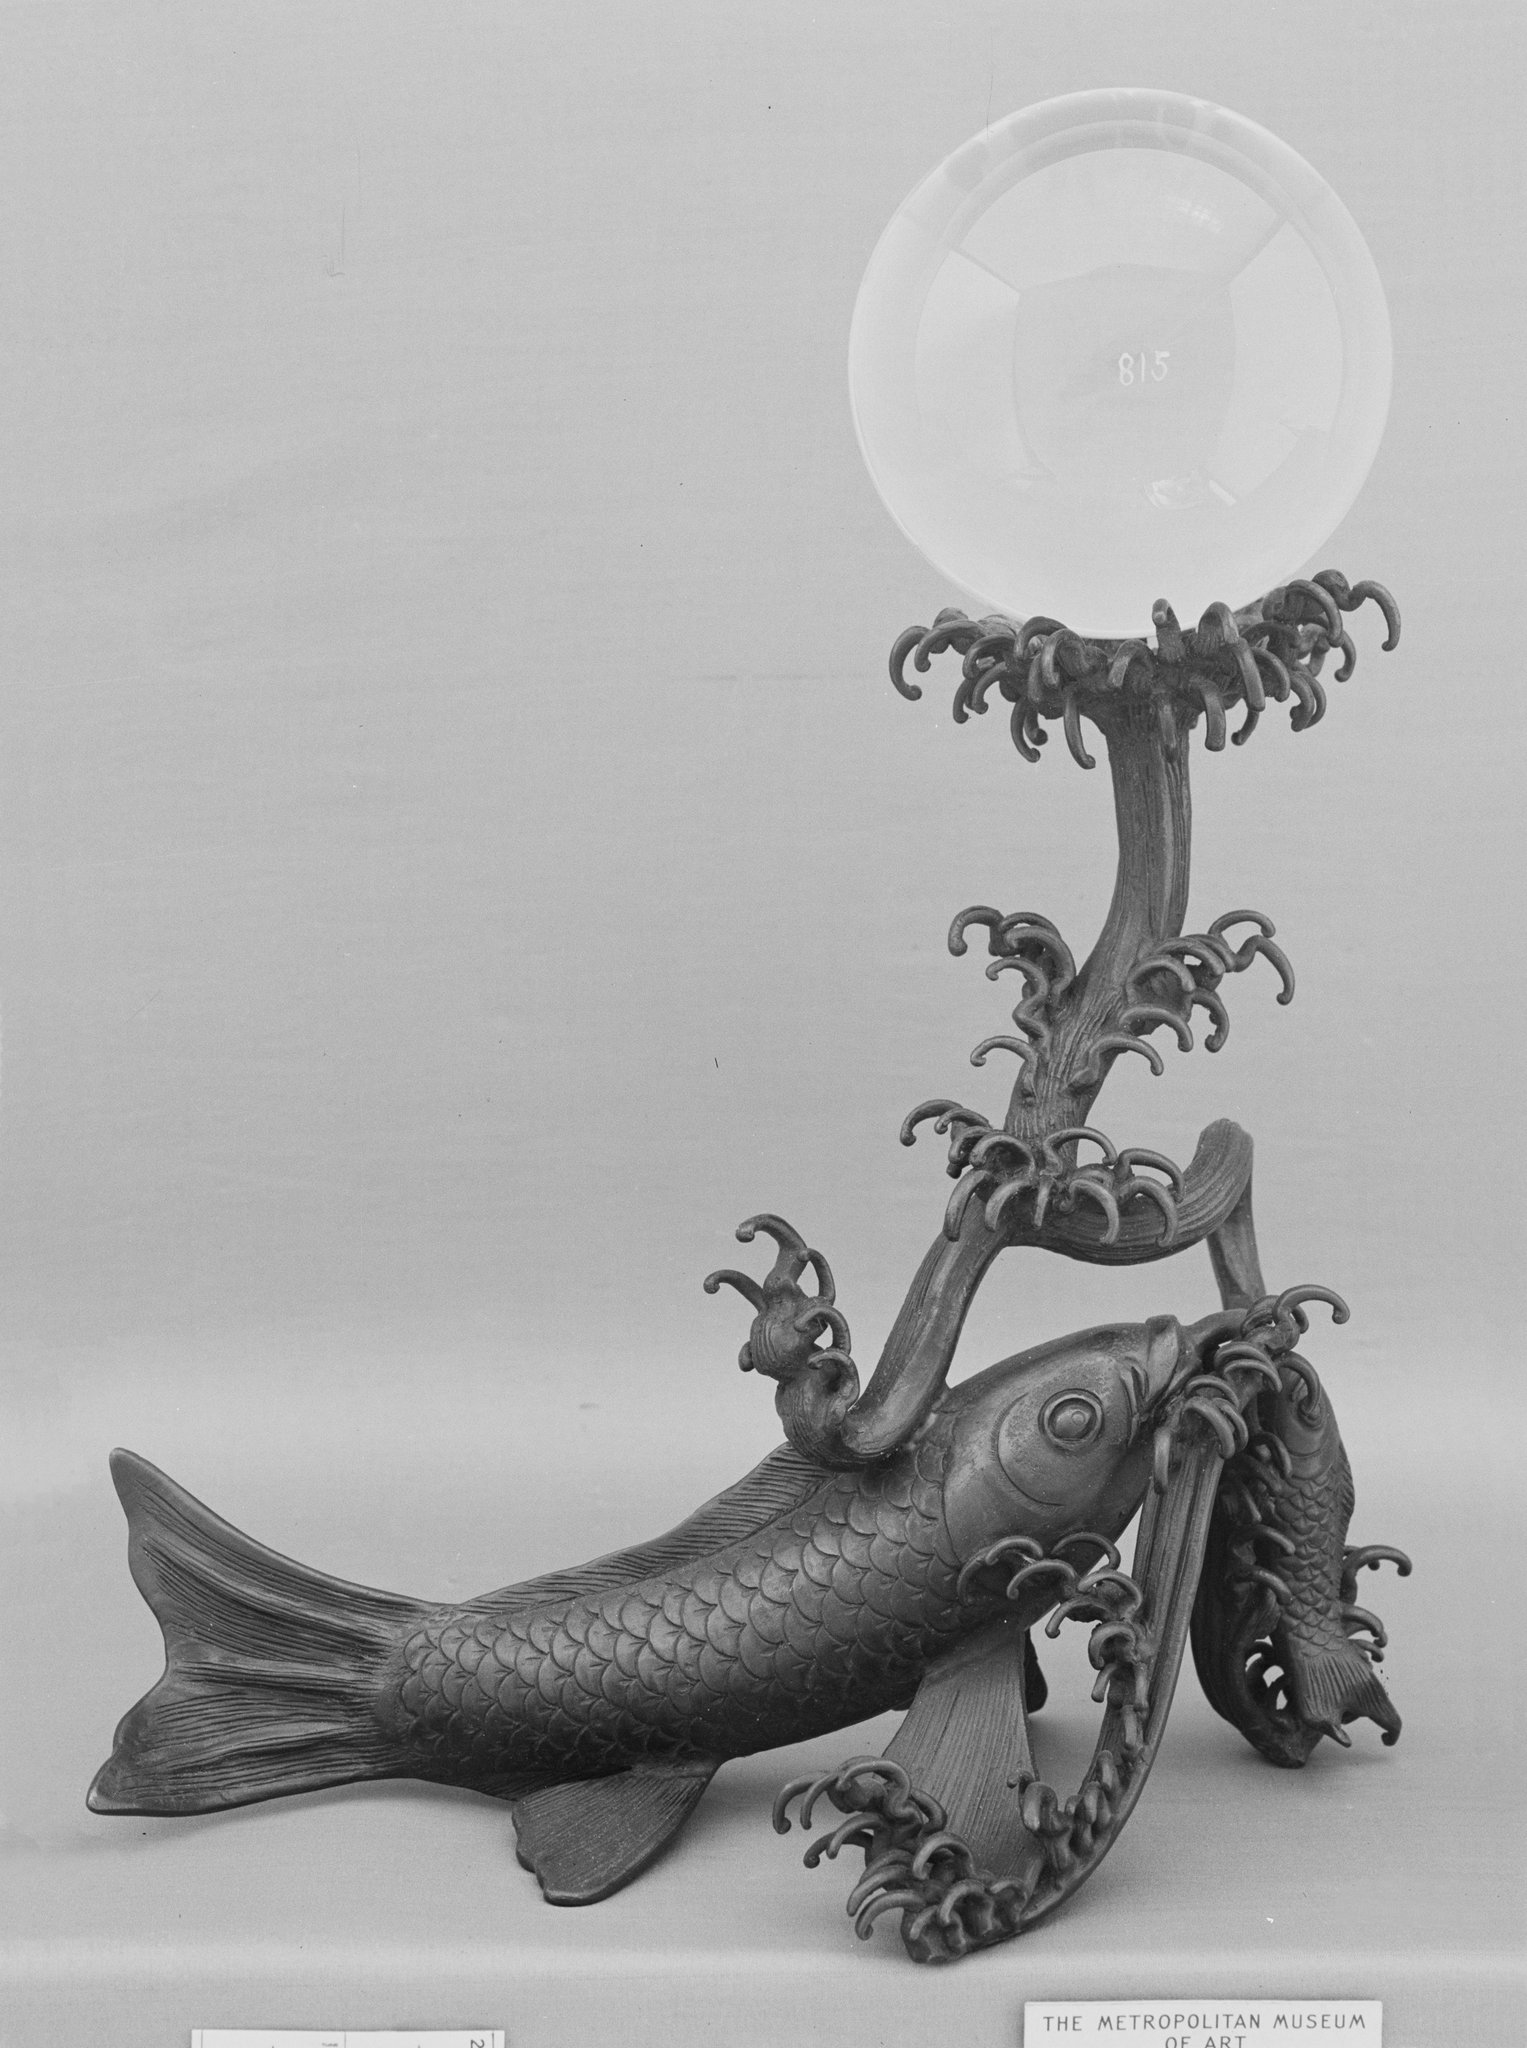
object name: crystal ball on stand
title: Crystal Ball on a Bronze Stand in the Shape of a Fish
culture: chinese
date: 1701-1800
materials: bronze, quartz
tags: fish